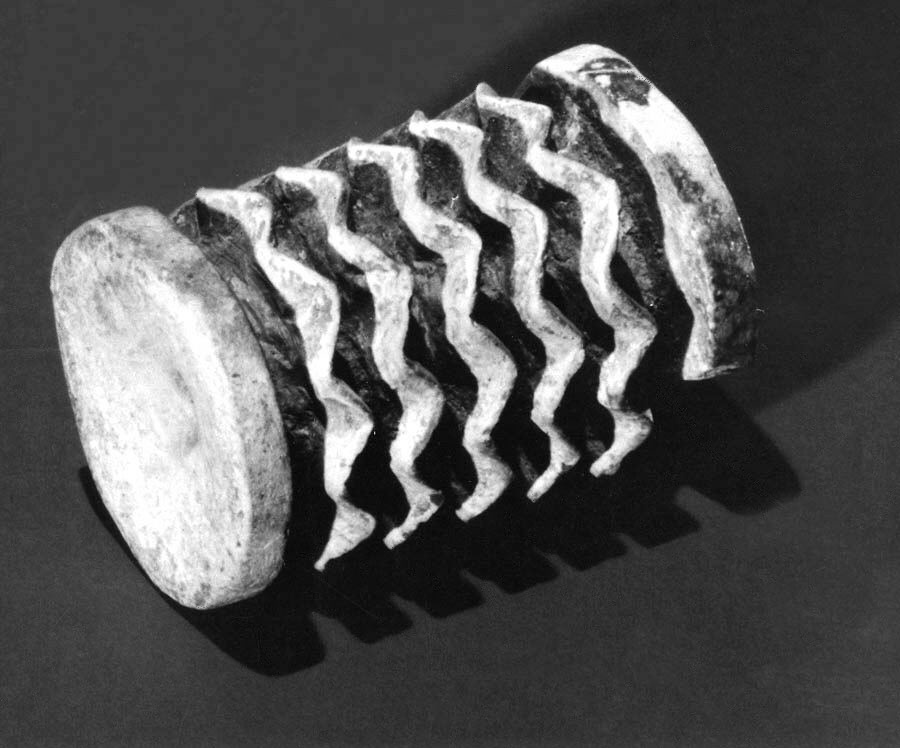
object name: paint roller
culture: thai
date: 3500 BCE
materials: pottery